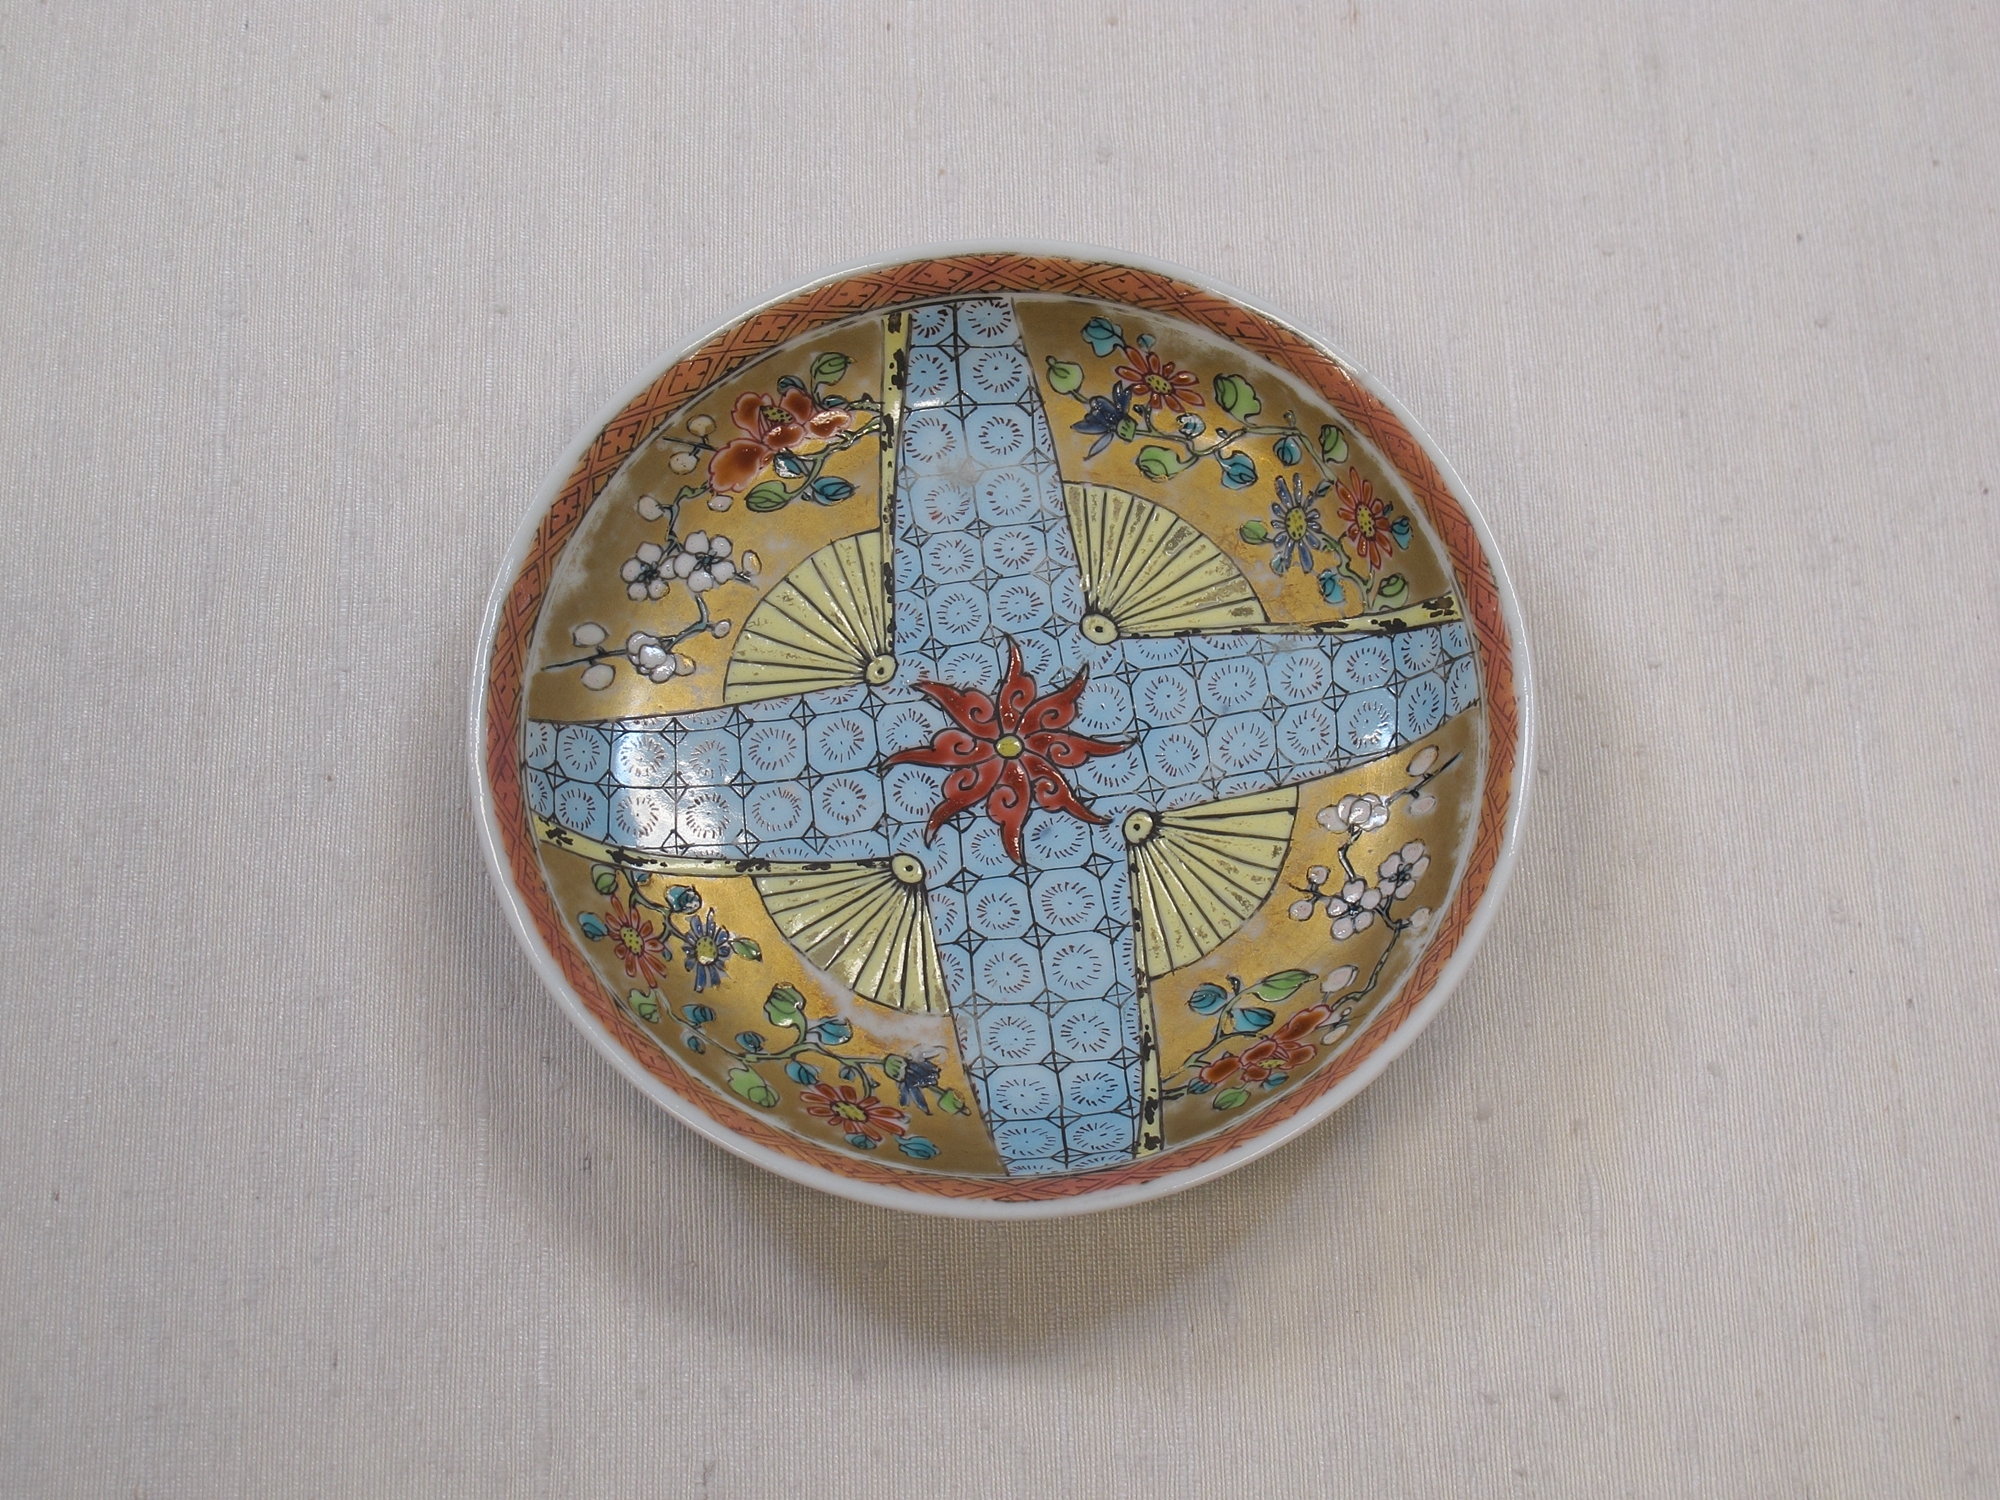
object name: saucer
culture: chinese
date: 1644-1911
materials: enamel, porcelain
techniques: overglaze, painting, polychrome